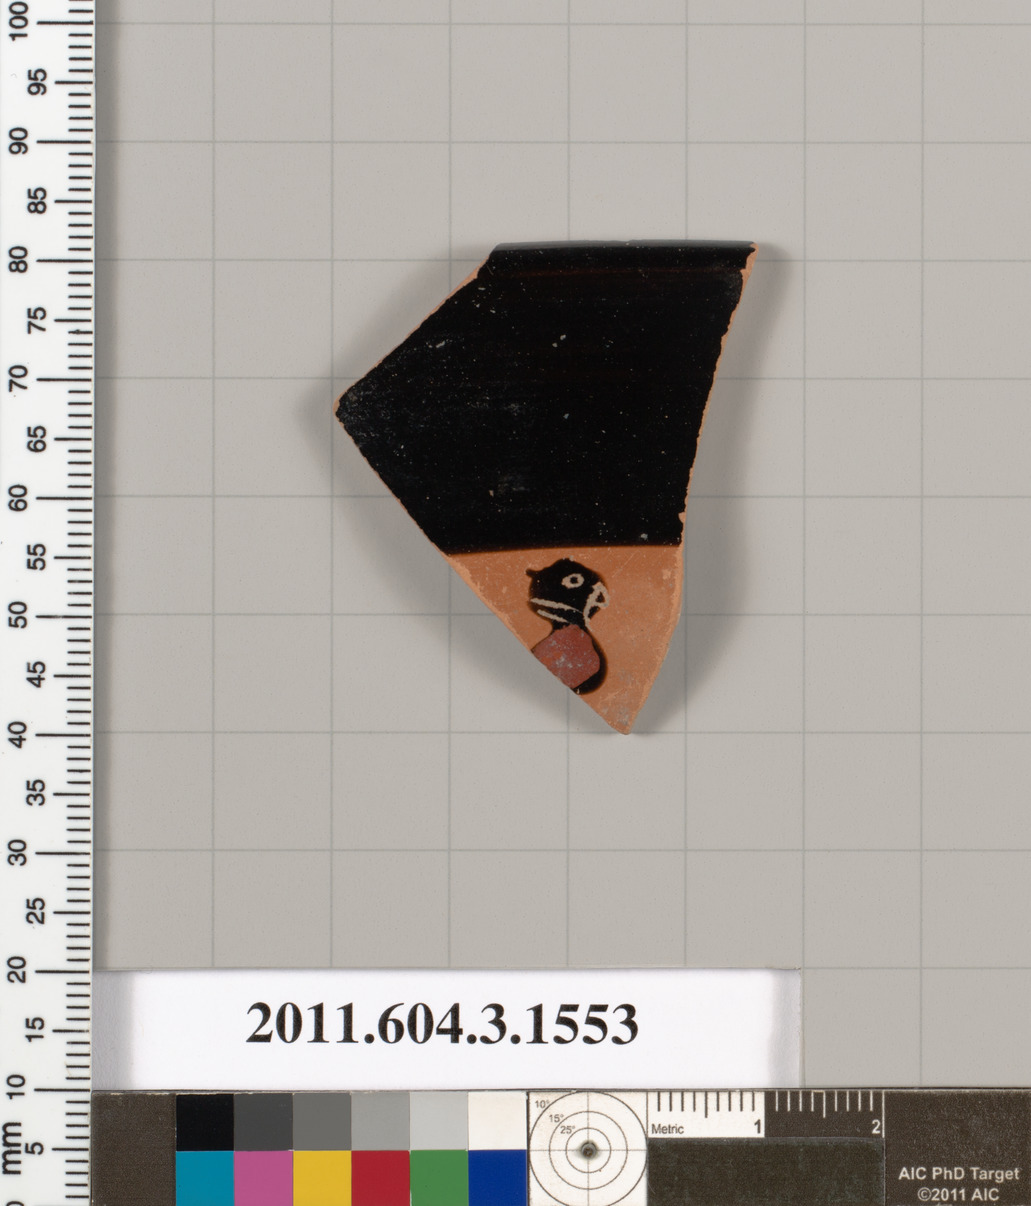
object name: kylix fragment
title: Terracotta rim fragment of a kylix: Band cup (drinking cup)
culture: greek, attic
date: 567-535 BCE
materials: terracotta